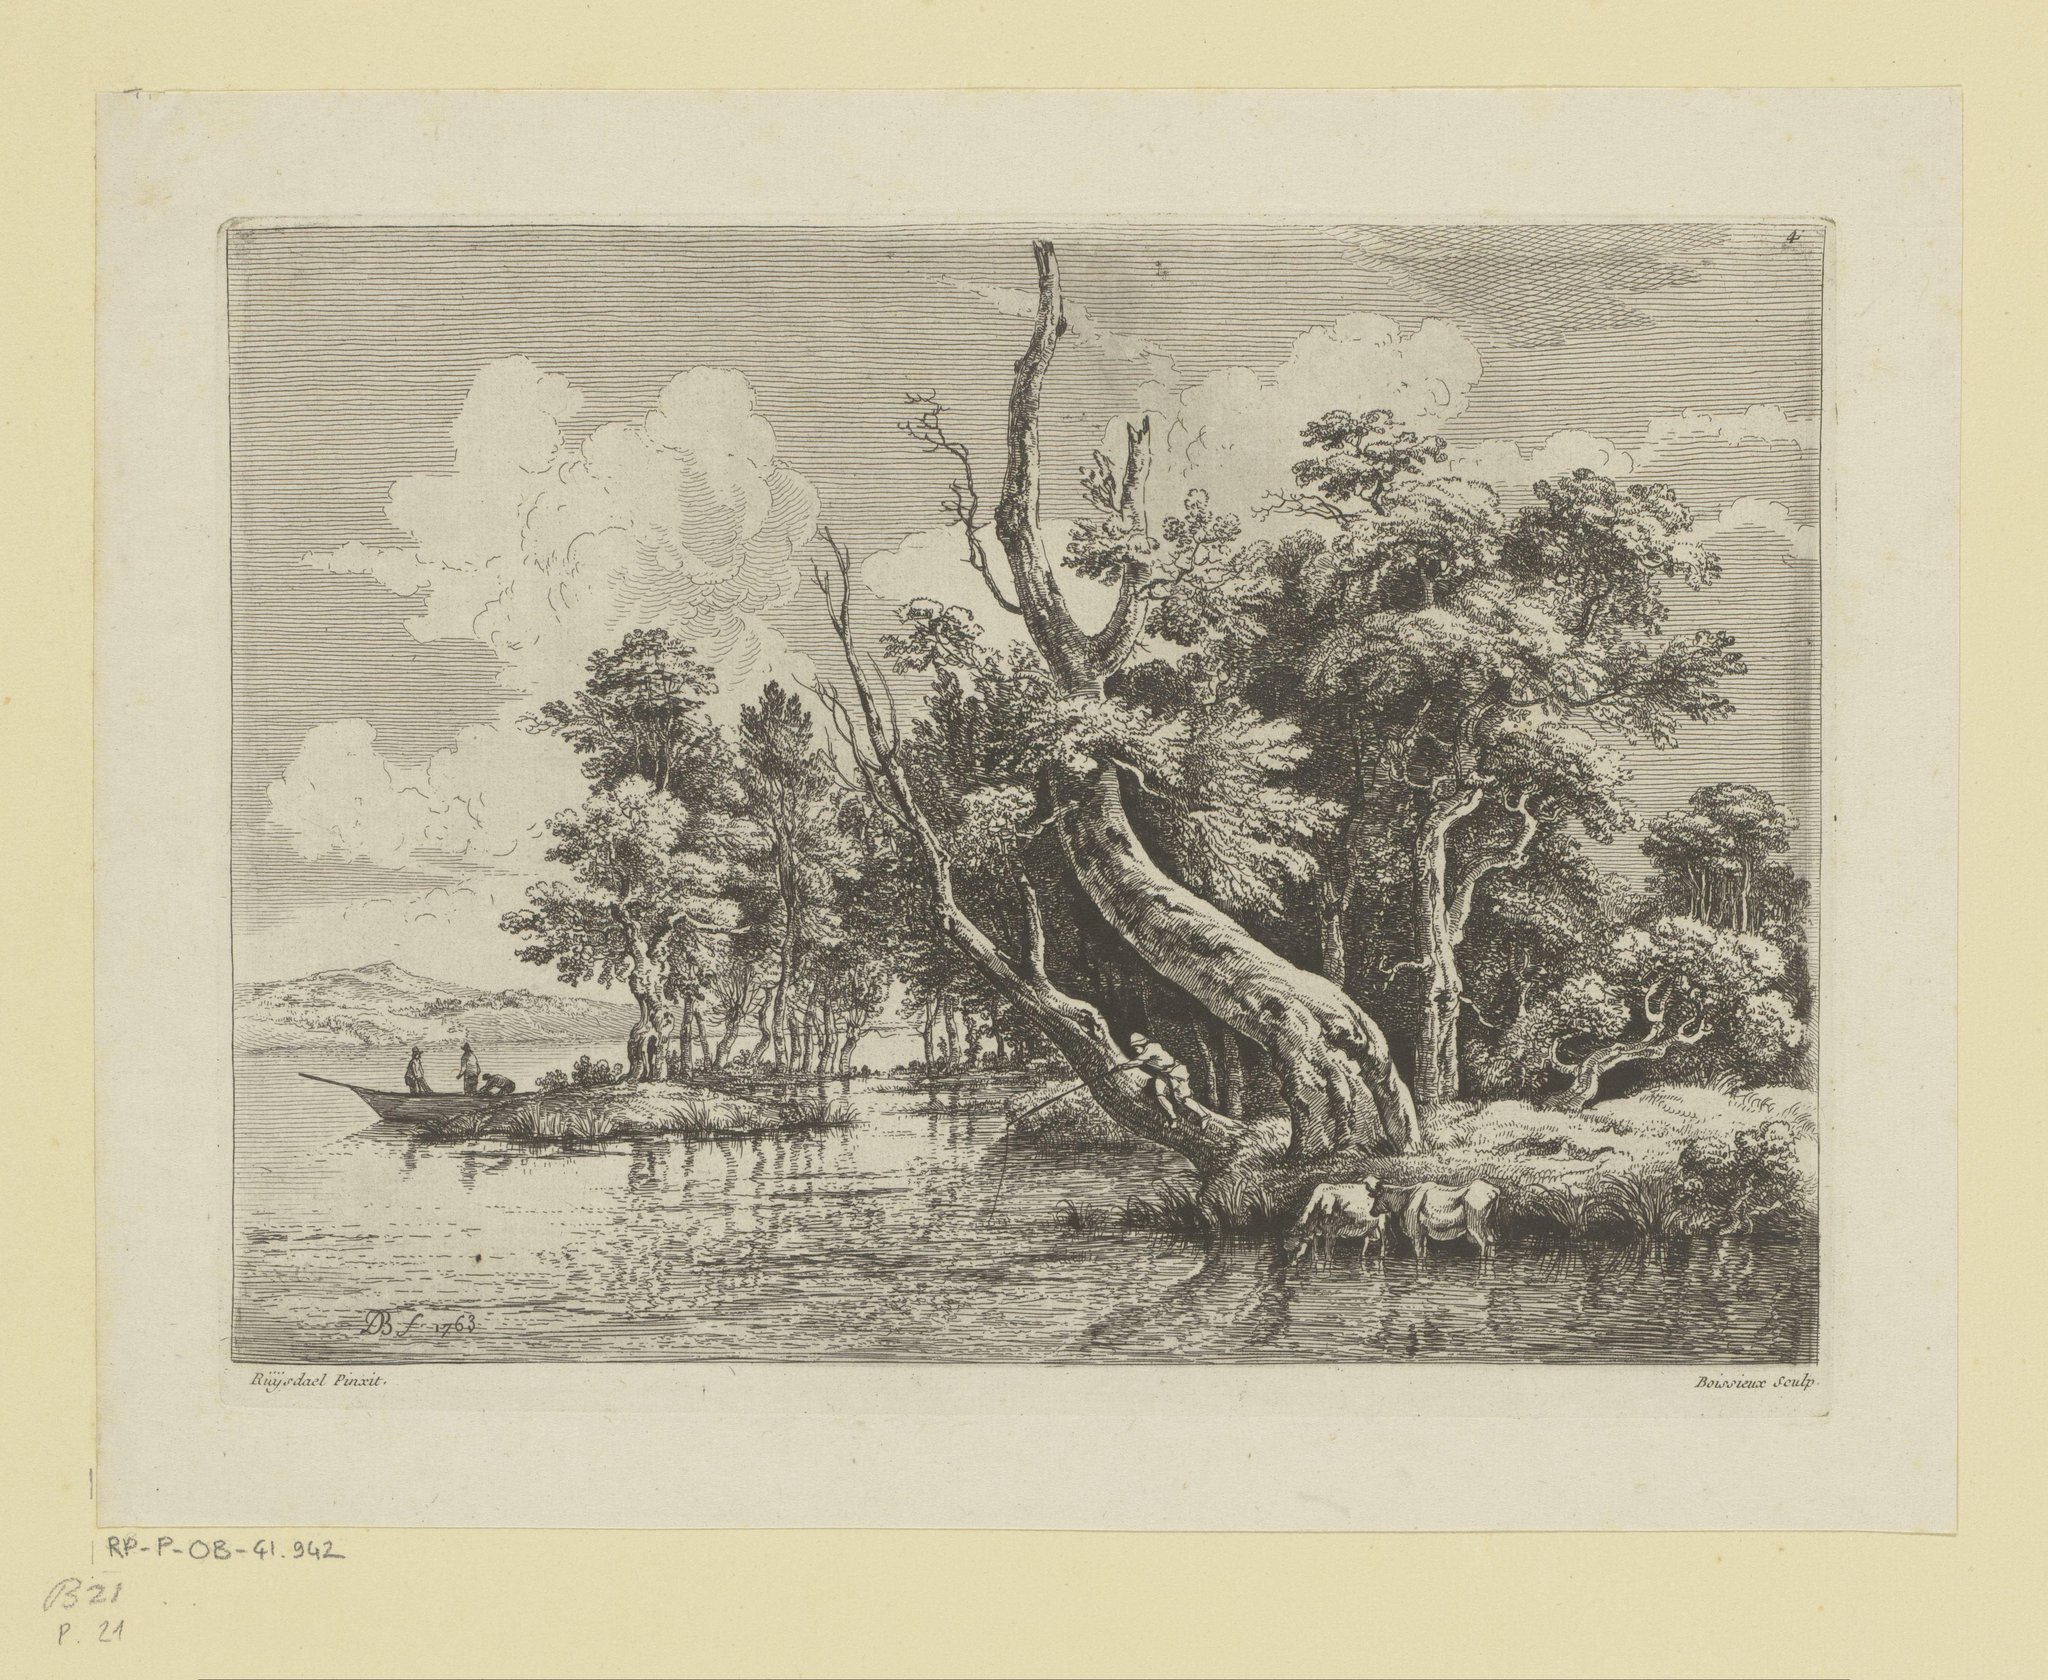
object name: print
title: Suite de dix Paysages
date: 1763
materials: paper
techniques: etching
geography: france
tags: landscapes with waters, waterscapes, seascapes (in the temperate zone), angling, fisherman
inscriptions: collector's mark: Lugt 12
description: Maakt deel uit van een tiendelige serie met landschappen, uitgegeven door Basan te Parijs in 1763.